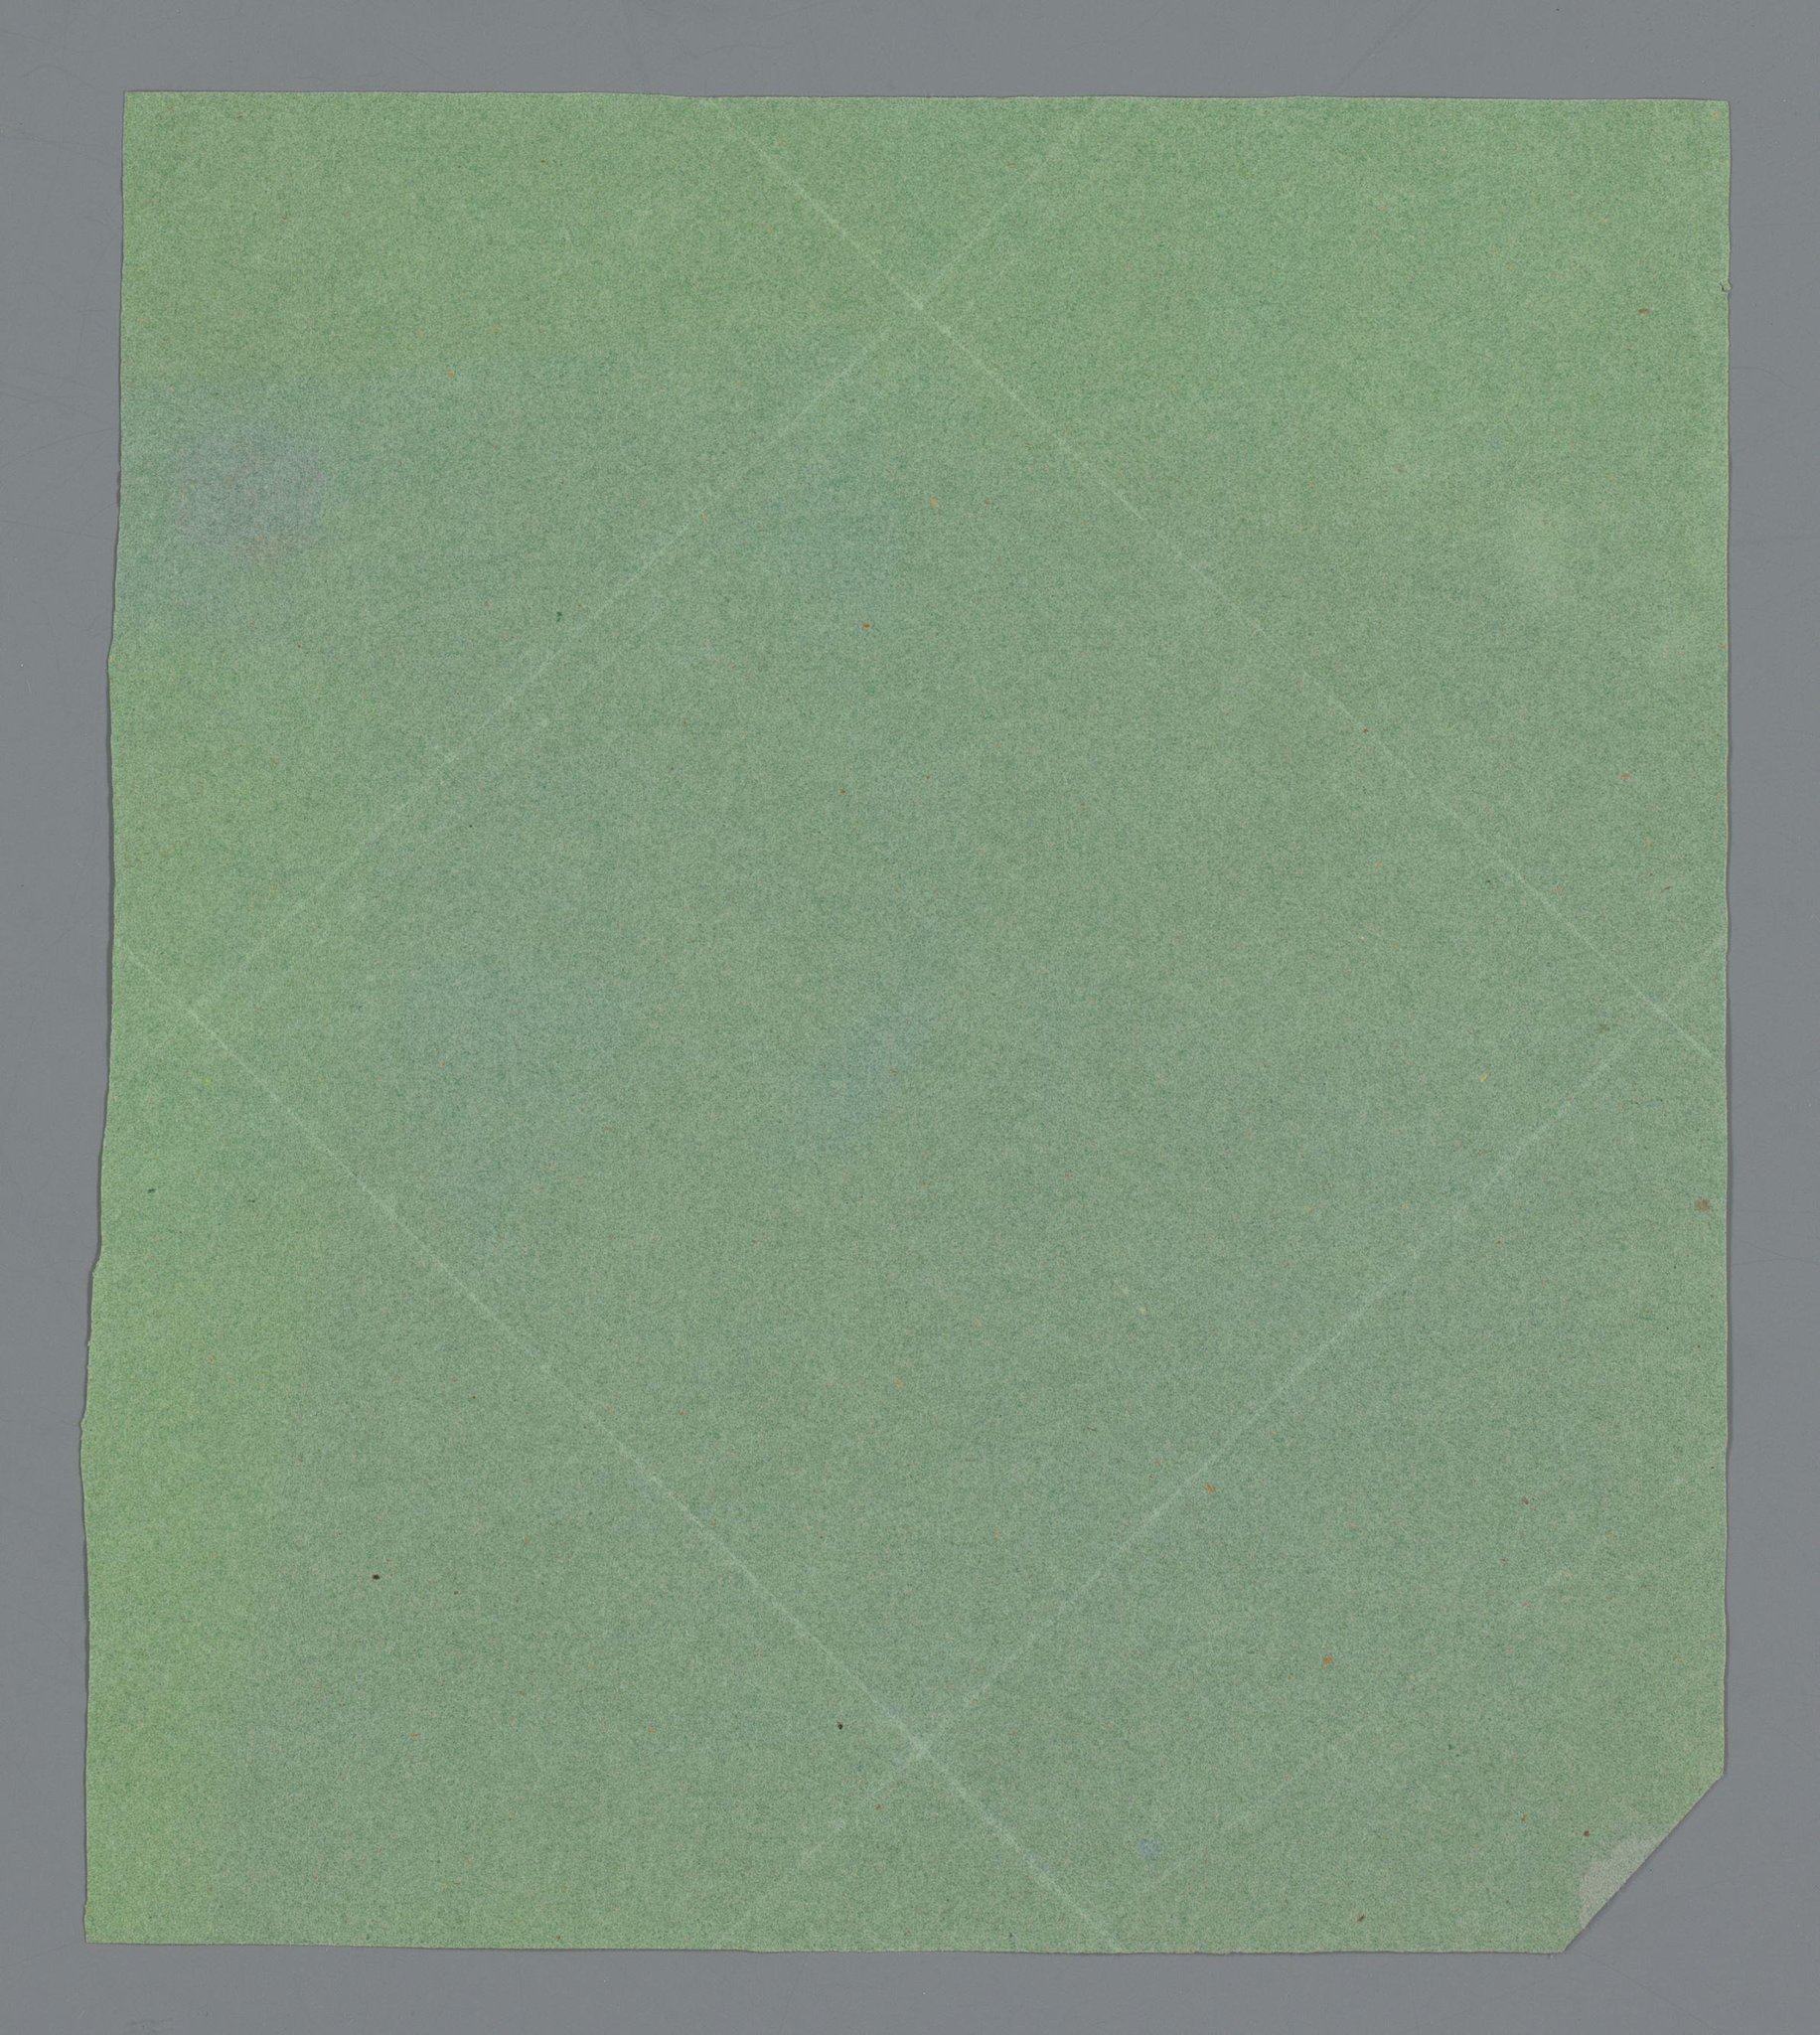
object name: decorated paper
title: Effen groen papier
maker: Anonymous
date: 1800-1900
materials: paint, paper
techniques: painting